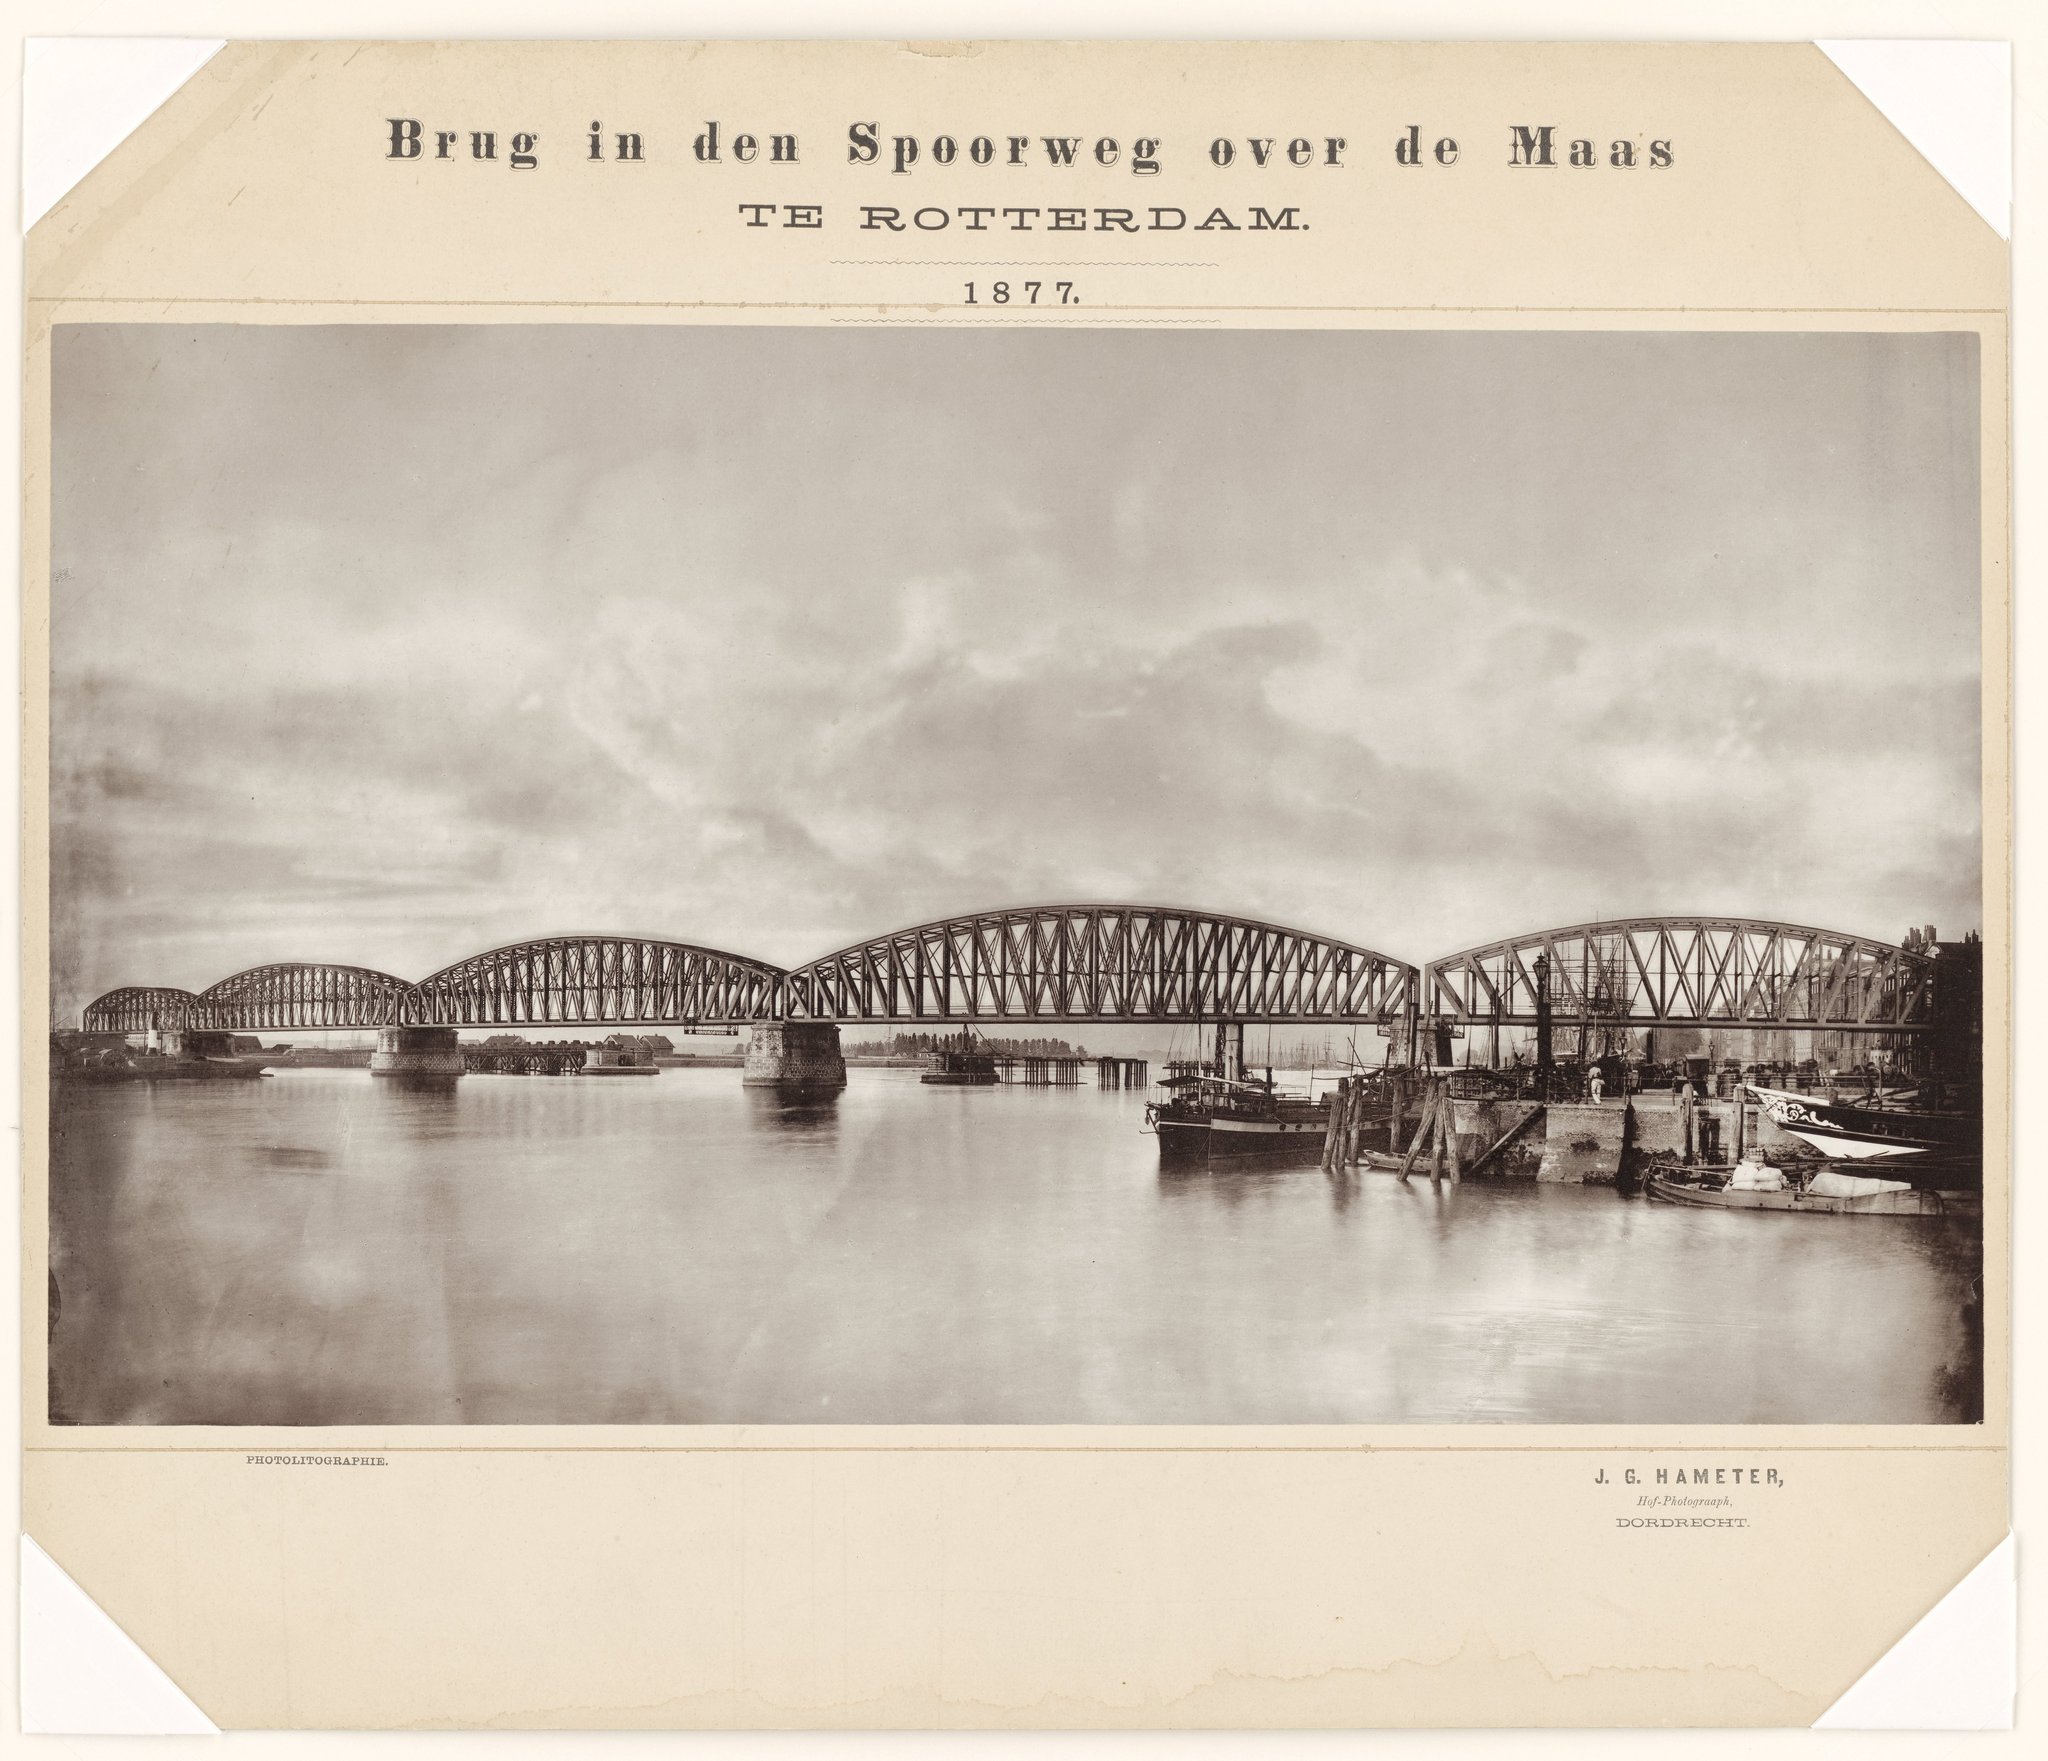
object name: photograph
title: Spoorbrug over de Maas bij Rotterdam, gezien vanaf het Oude Hoofdplein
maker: johann georg hameter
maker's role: fotograaf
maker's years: 1838-1885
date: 1877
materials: cardboard, paper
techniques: photograph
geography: dordrecht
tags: bridge in city across river, canal, etc., rotterdam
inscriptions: date